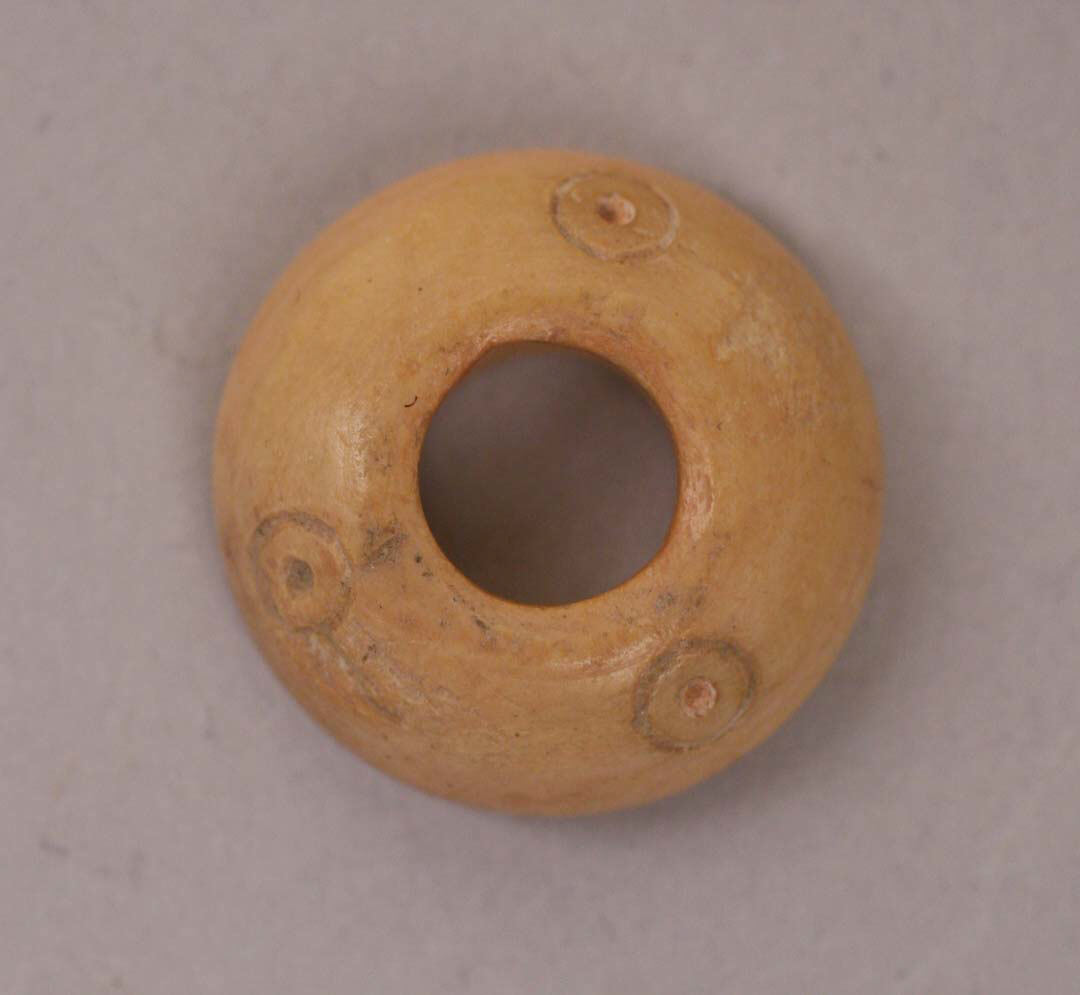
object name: button or bead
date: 801-1000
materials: bone, paint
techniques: incising, inlay, tinting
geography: iran